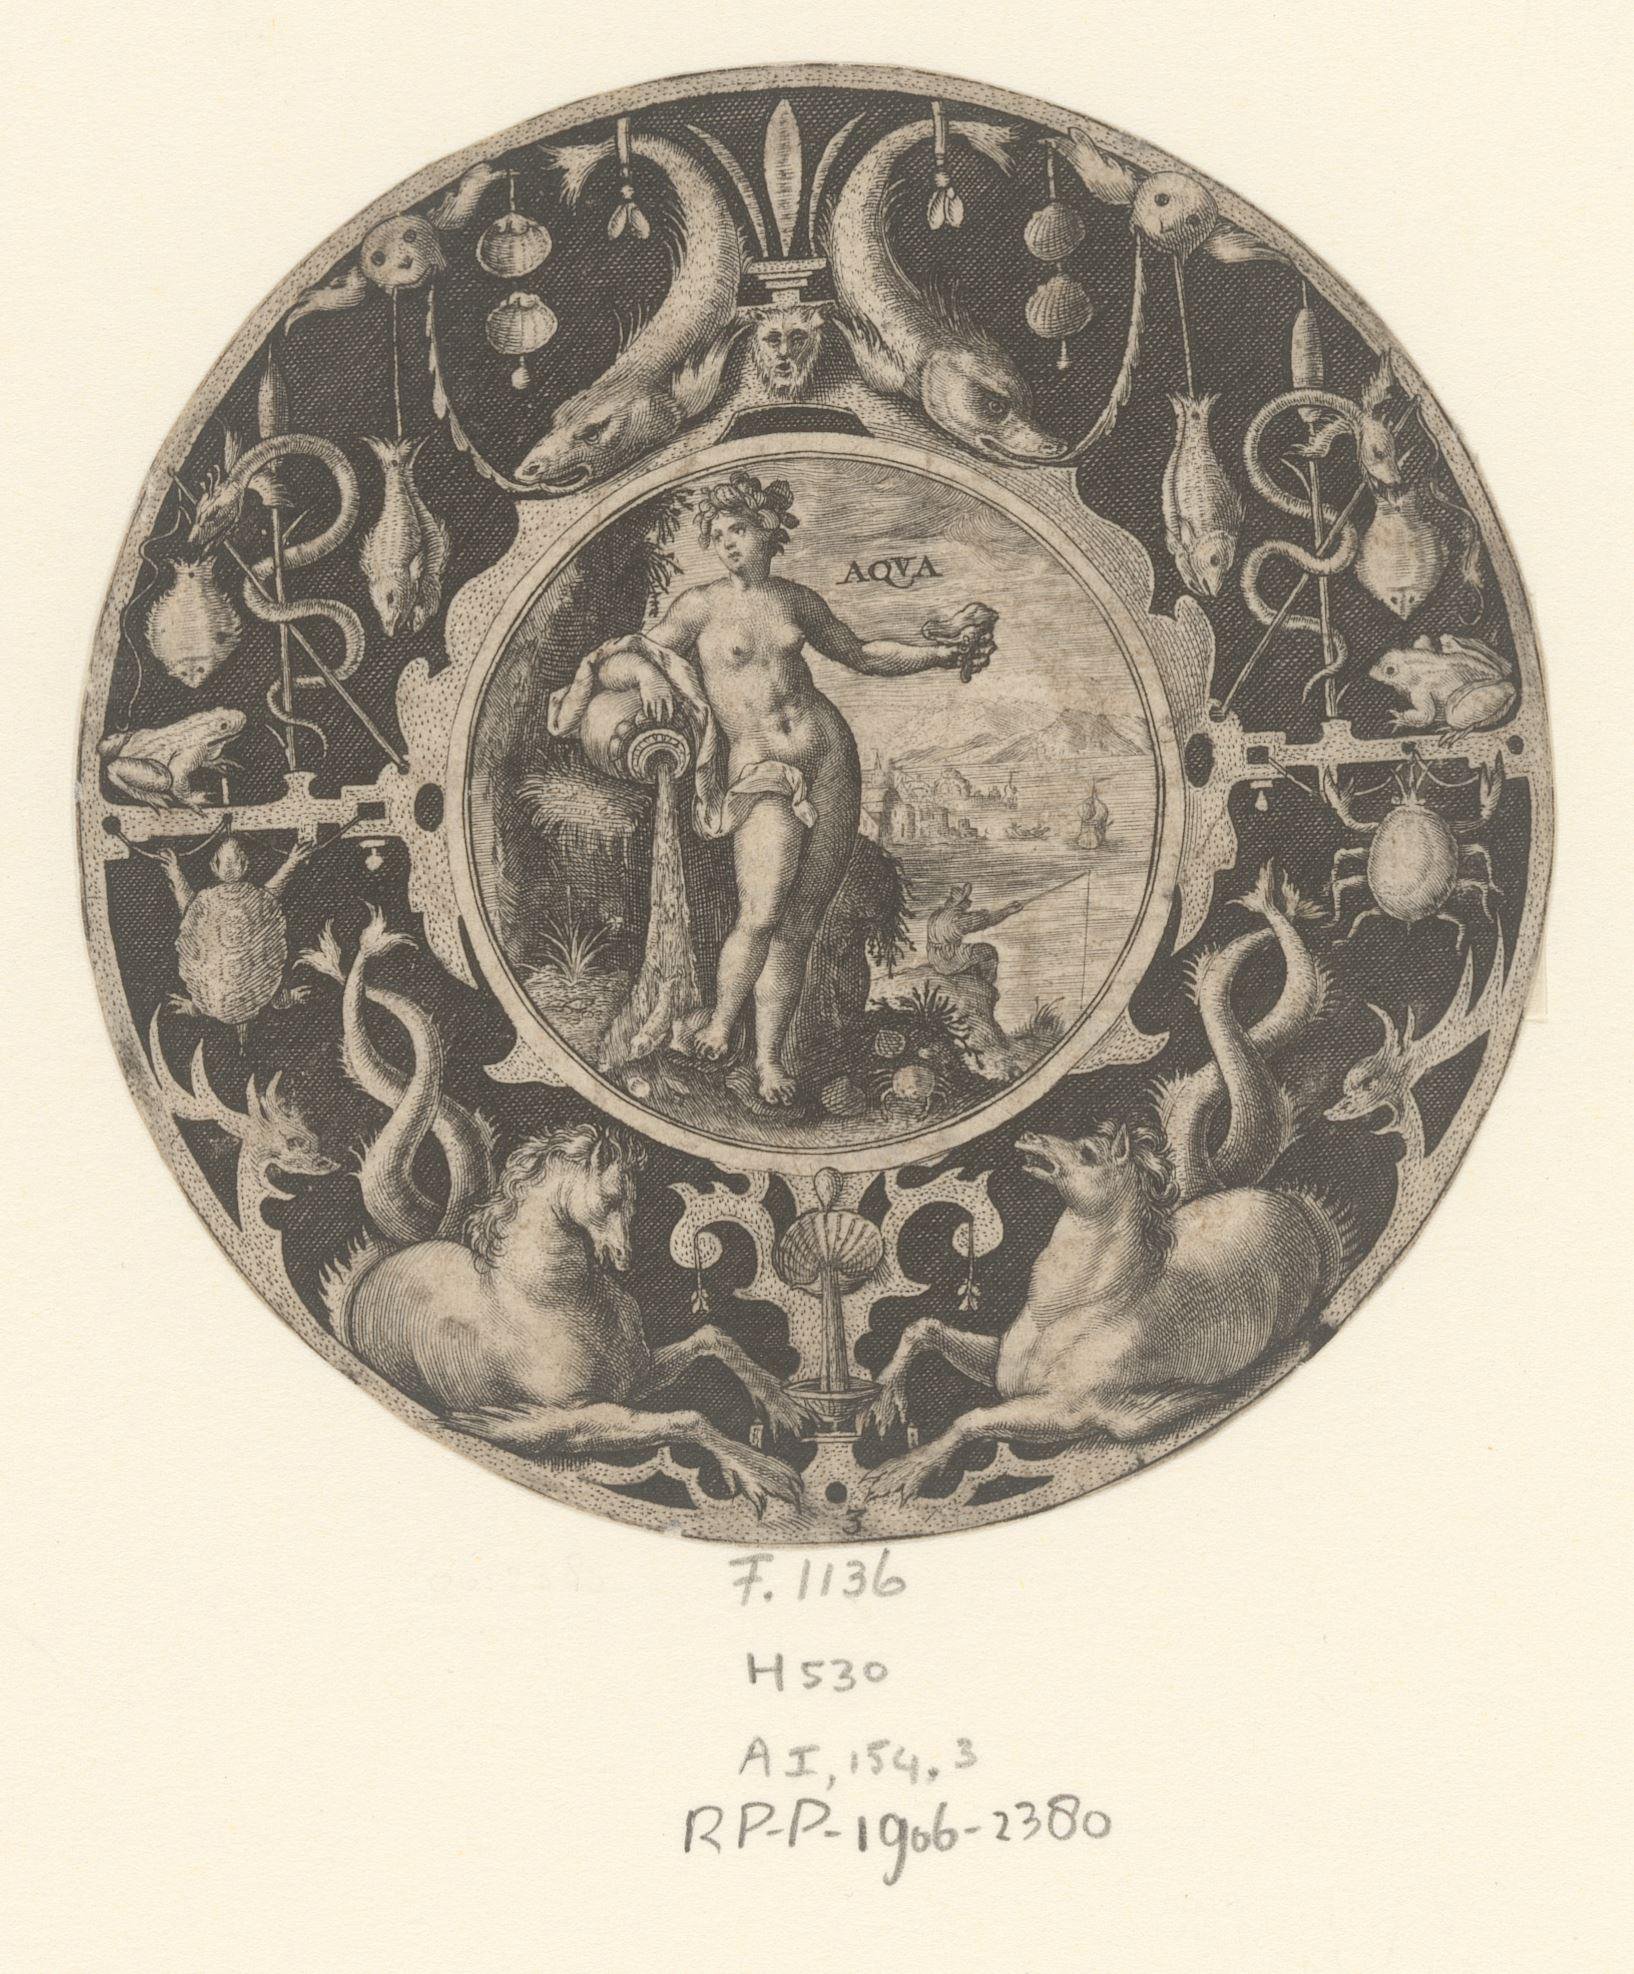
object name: print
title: Aqva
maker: crispijn van de passe (i)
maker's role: draughtsman, print maker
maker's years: 1564-1637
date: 1574-1637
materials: paper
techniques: engraving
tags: water (one of the four elements), fishes, fisherman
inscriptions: collector's mark: Lugt 2228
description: Landschap met de vrouwelijke personificatie van het element water, met een gekantelde urn waar water uitstroomt. Op de achtergrond een visser. De prent heeft een ornamentele rand die is versierd met vissen en dieren die het element symboliseren.